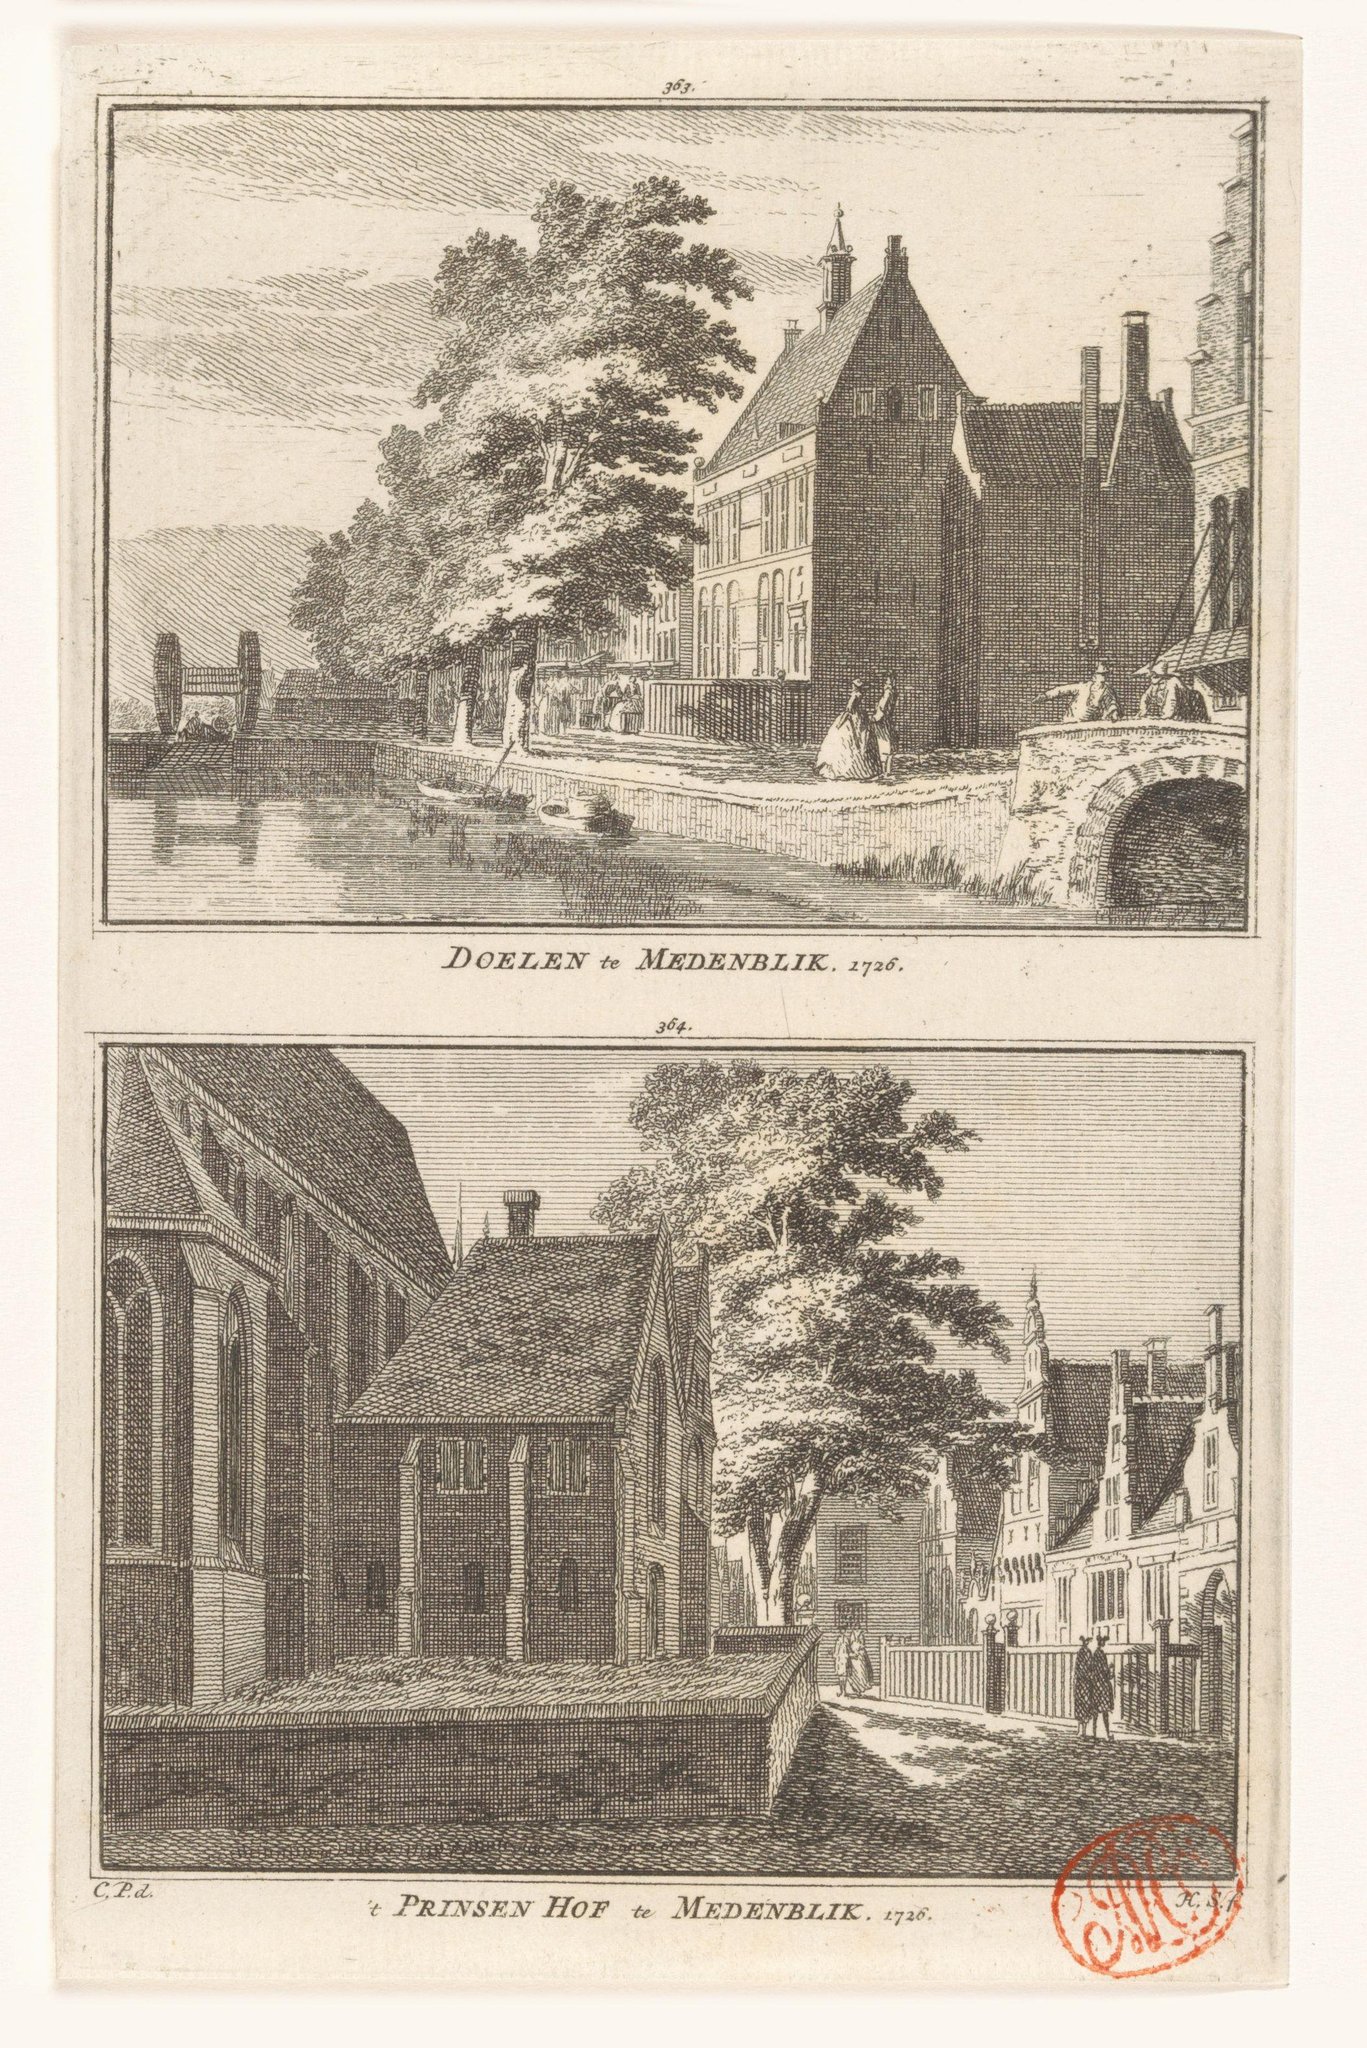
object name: book illustration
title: Doelen te Medenblik. 1726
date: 1752-1792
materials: paper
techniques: engraving, etching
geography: haarlem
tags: exterior ~ representation of a building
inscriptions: collector's mark: Lugt 195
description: Prent ook gebruikt in: Het verheerlykt Nederland of kabinet van hedendaagsche gezigten van steden, dorpen (…). 9 delen. Amsterdam: Isaak Tirion en weduwe Isaak Tirion, 1745-1774, dl. 4 (1752), ill. 363 en 364. Of in: Nederlandsche tafereelen; of eene keurige verzameling van negen honderd fraaije gezigten van steden, dorpen, sloten, oudheden (….). 9 delen. Amsterdam: Jan de Groot, 1792, dl. 4, ill. 363 en 364. Uit welke druk het huidige exemplaar precies komt is niet na te gaan.